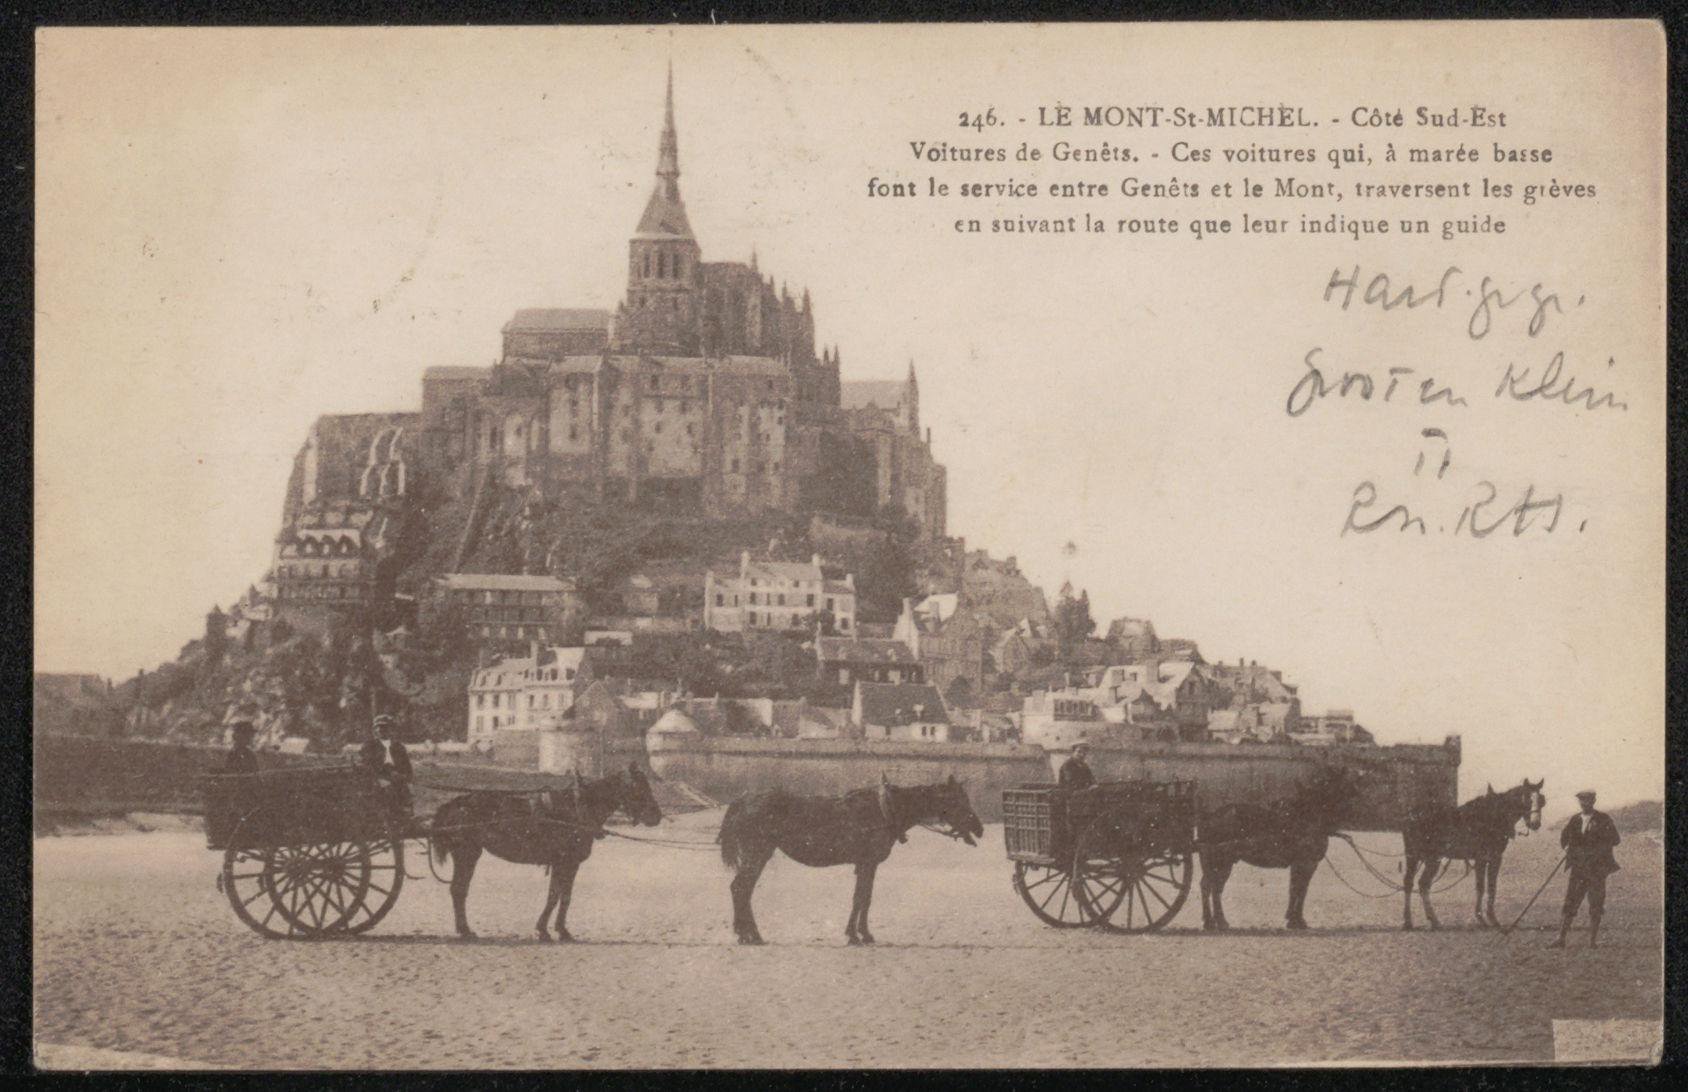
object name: ansichtkaart, prentbriefkaart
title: Prentbriefkaart aan Willem Bogtman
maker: richard nicolaüs roland holst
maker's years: 1868-1938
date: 1926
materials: cardboard, pencil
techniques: photograph, pen, writing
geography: france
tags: haarlem, willem bogtman, travelling; tourism